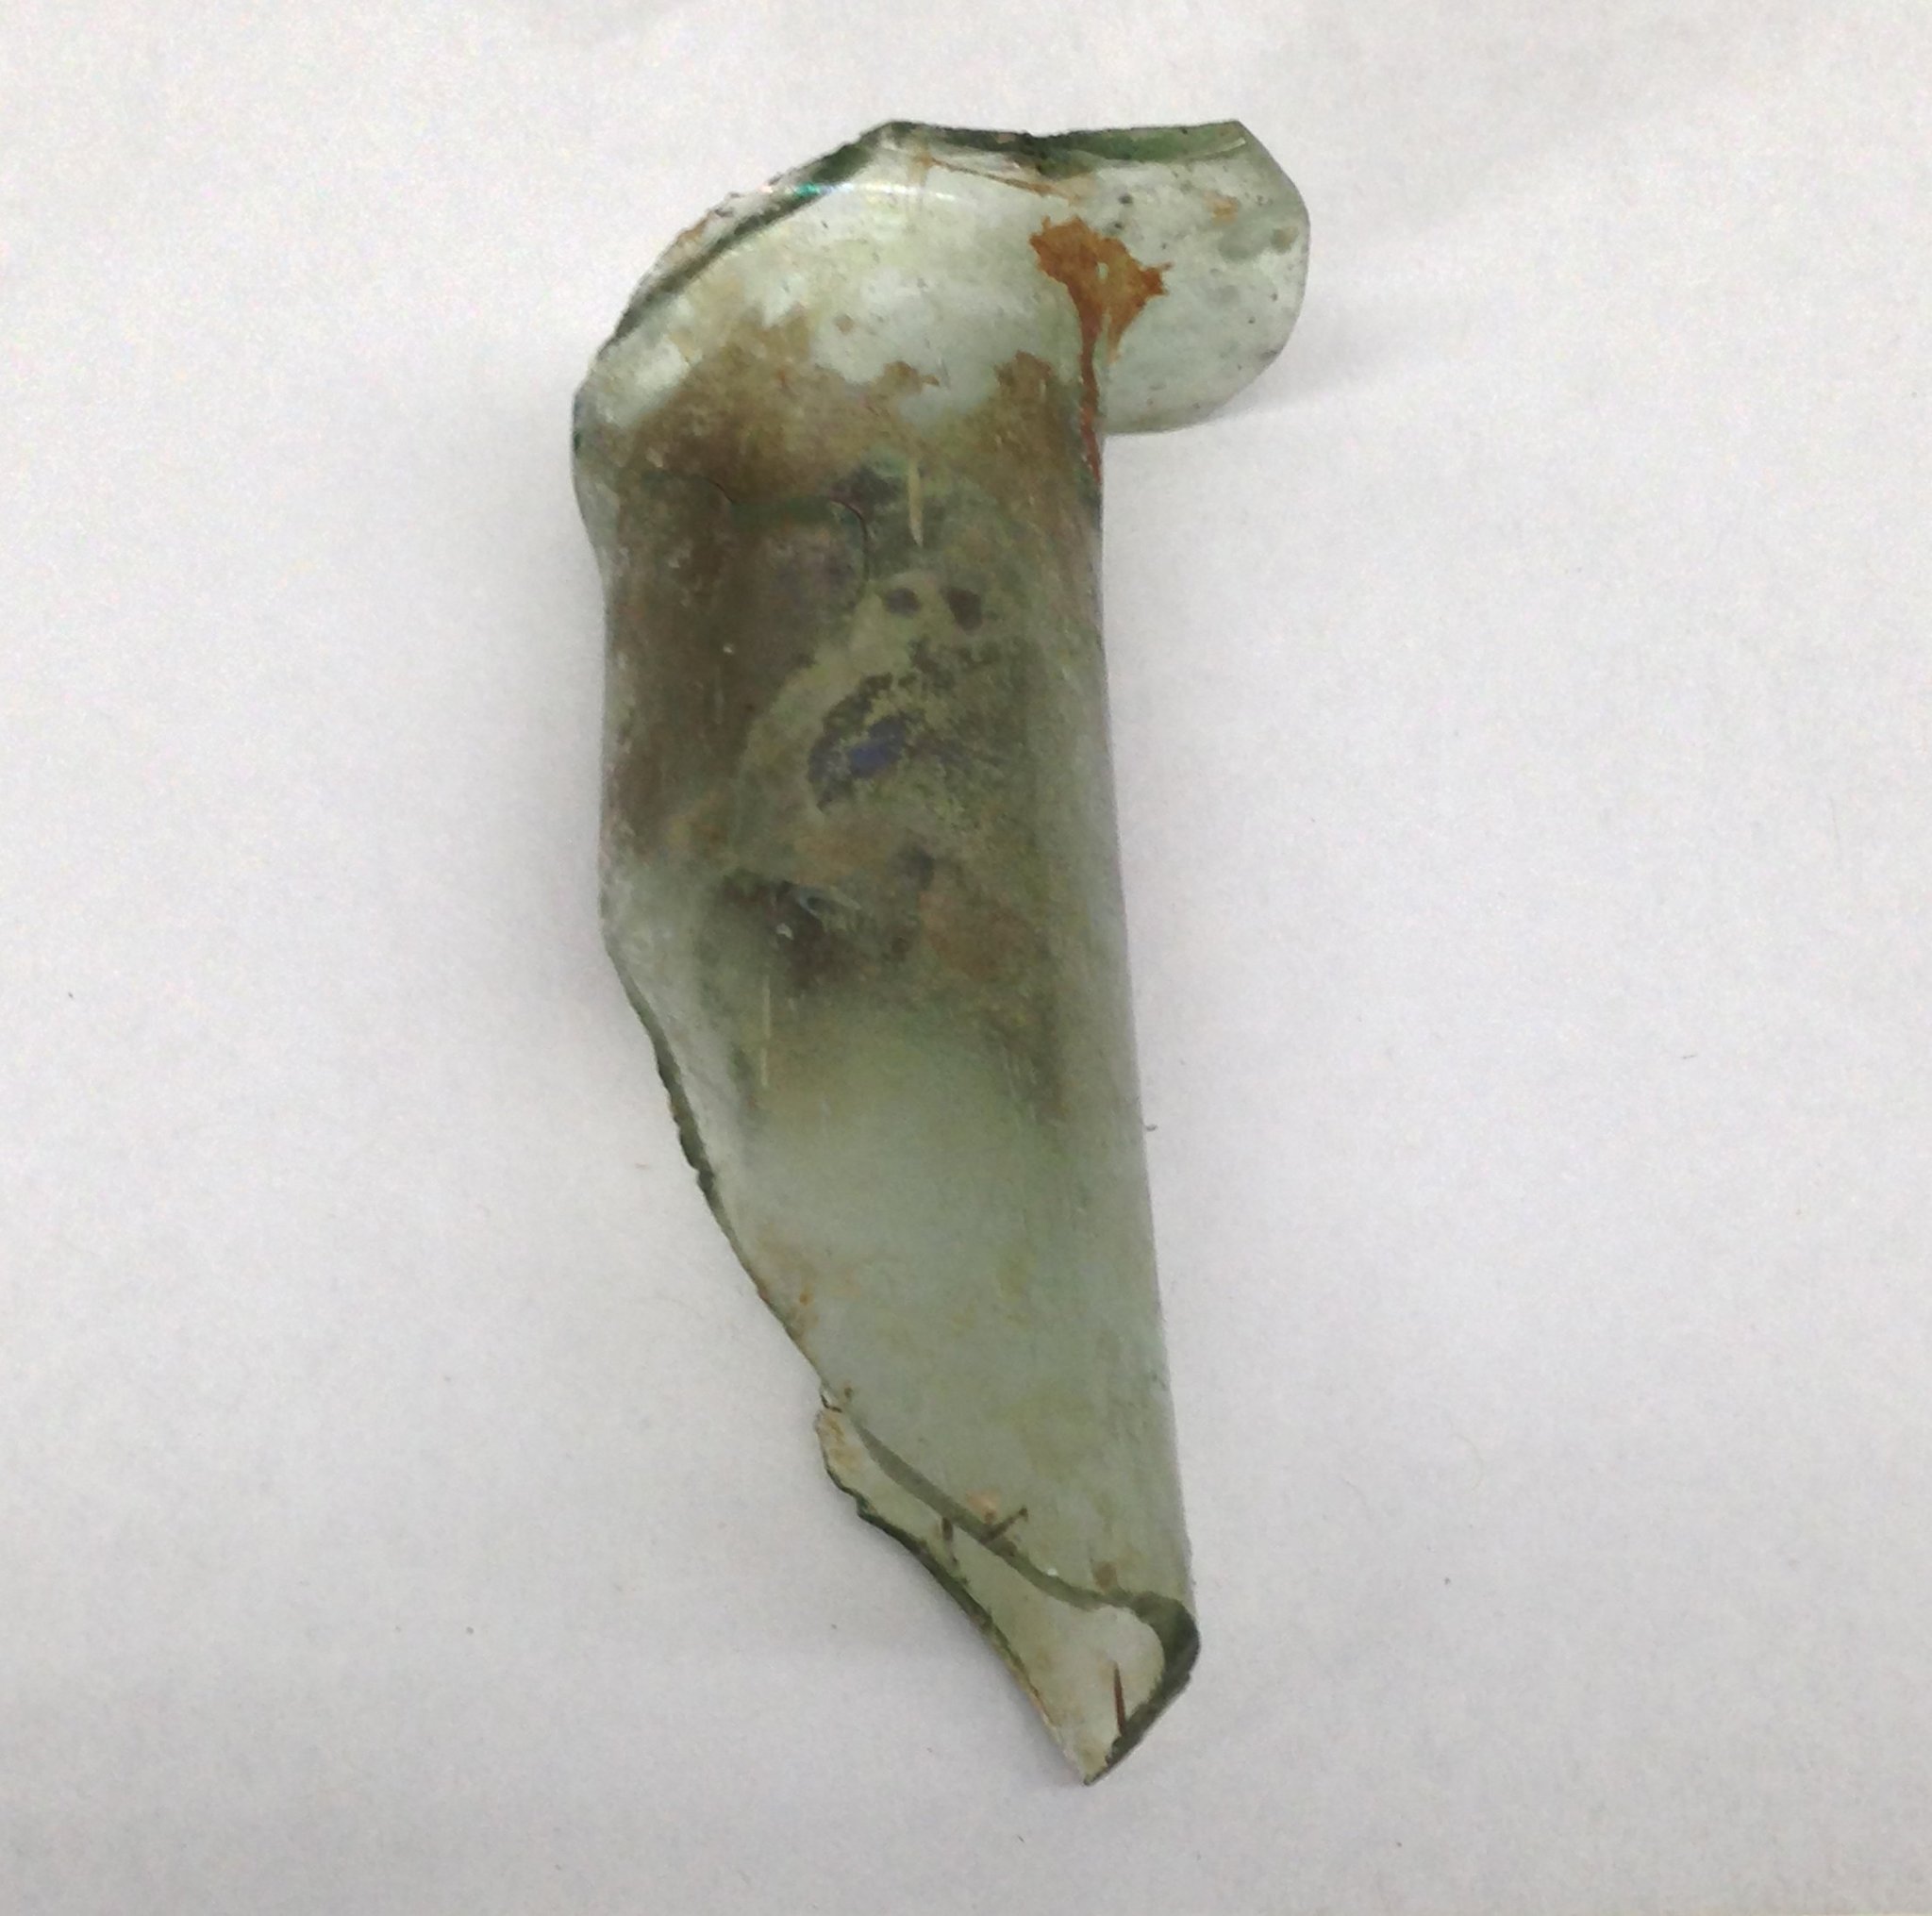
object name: fragment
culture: european or middle eastern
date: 1150-1250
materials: ceramic, glass